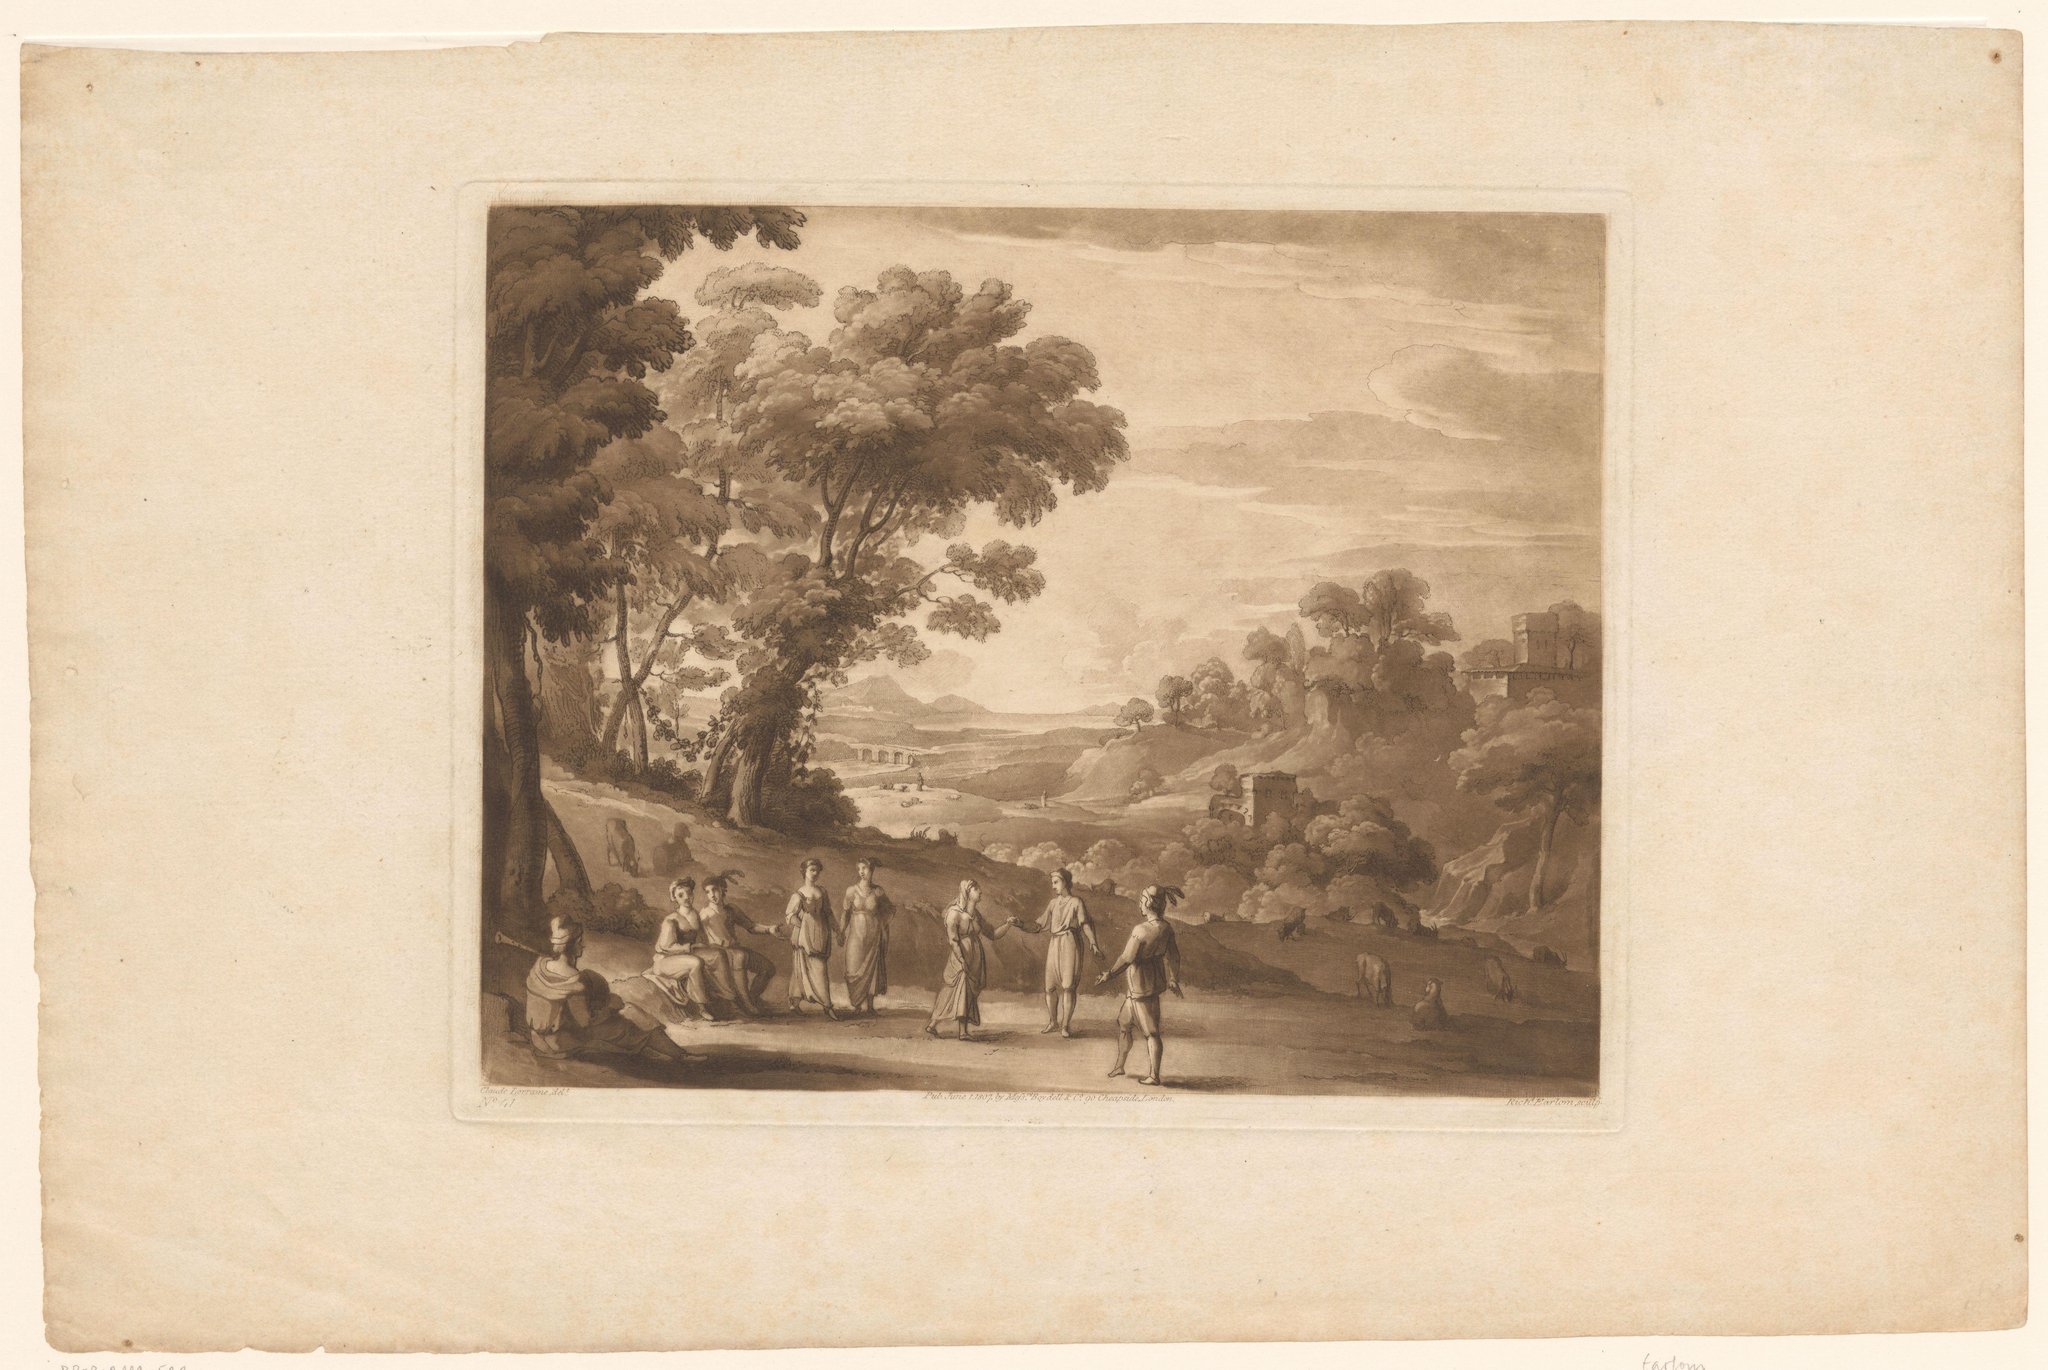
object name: print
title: Landschap met dansende figuren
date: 1807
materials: paper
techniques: etching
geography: london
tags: hurdy-gurdy player - cc - out of doors, folk dancing (men and women together), pastorals, arcadian scenes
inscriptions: collector's mark: Lugt 2228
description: De prent werd in 1819 nogmaals gebonden uitgegeven: Earlom, Richard. Liber Veritatis; or A Collection of Prints, after the Original Designs of Claude le Lorrain (...). Londen: Hurst, Robinson & Co., 1819.